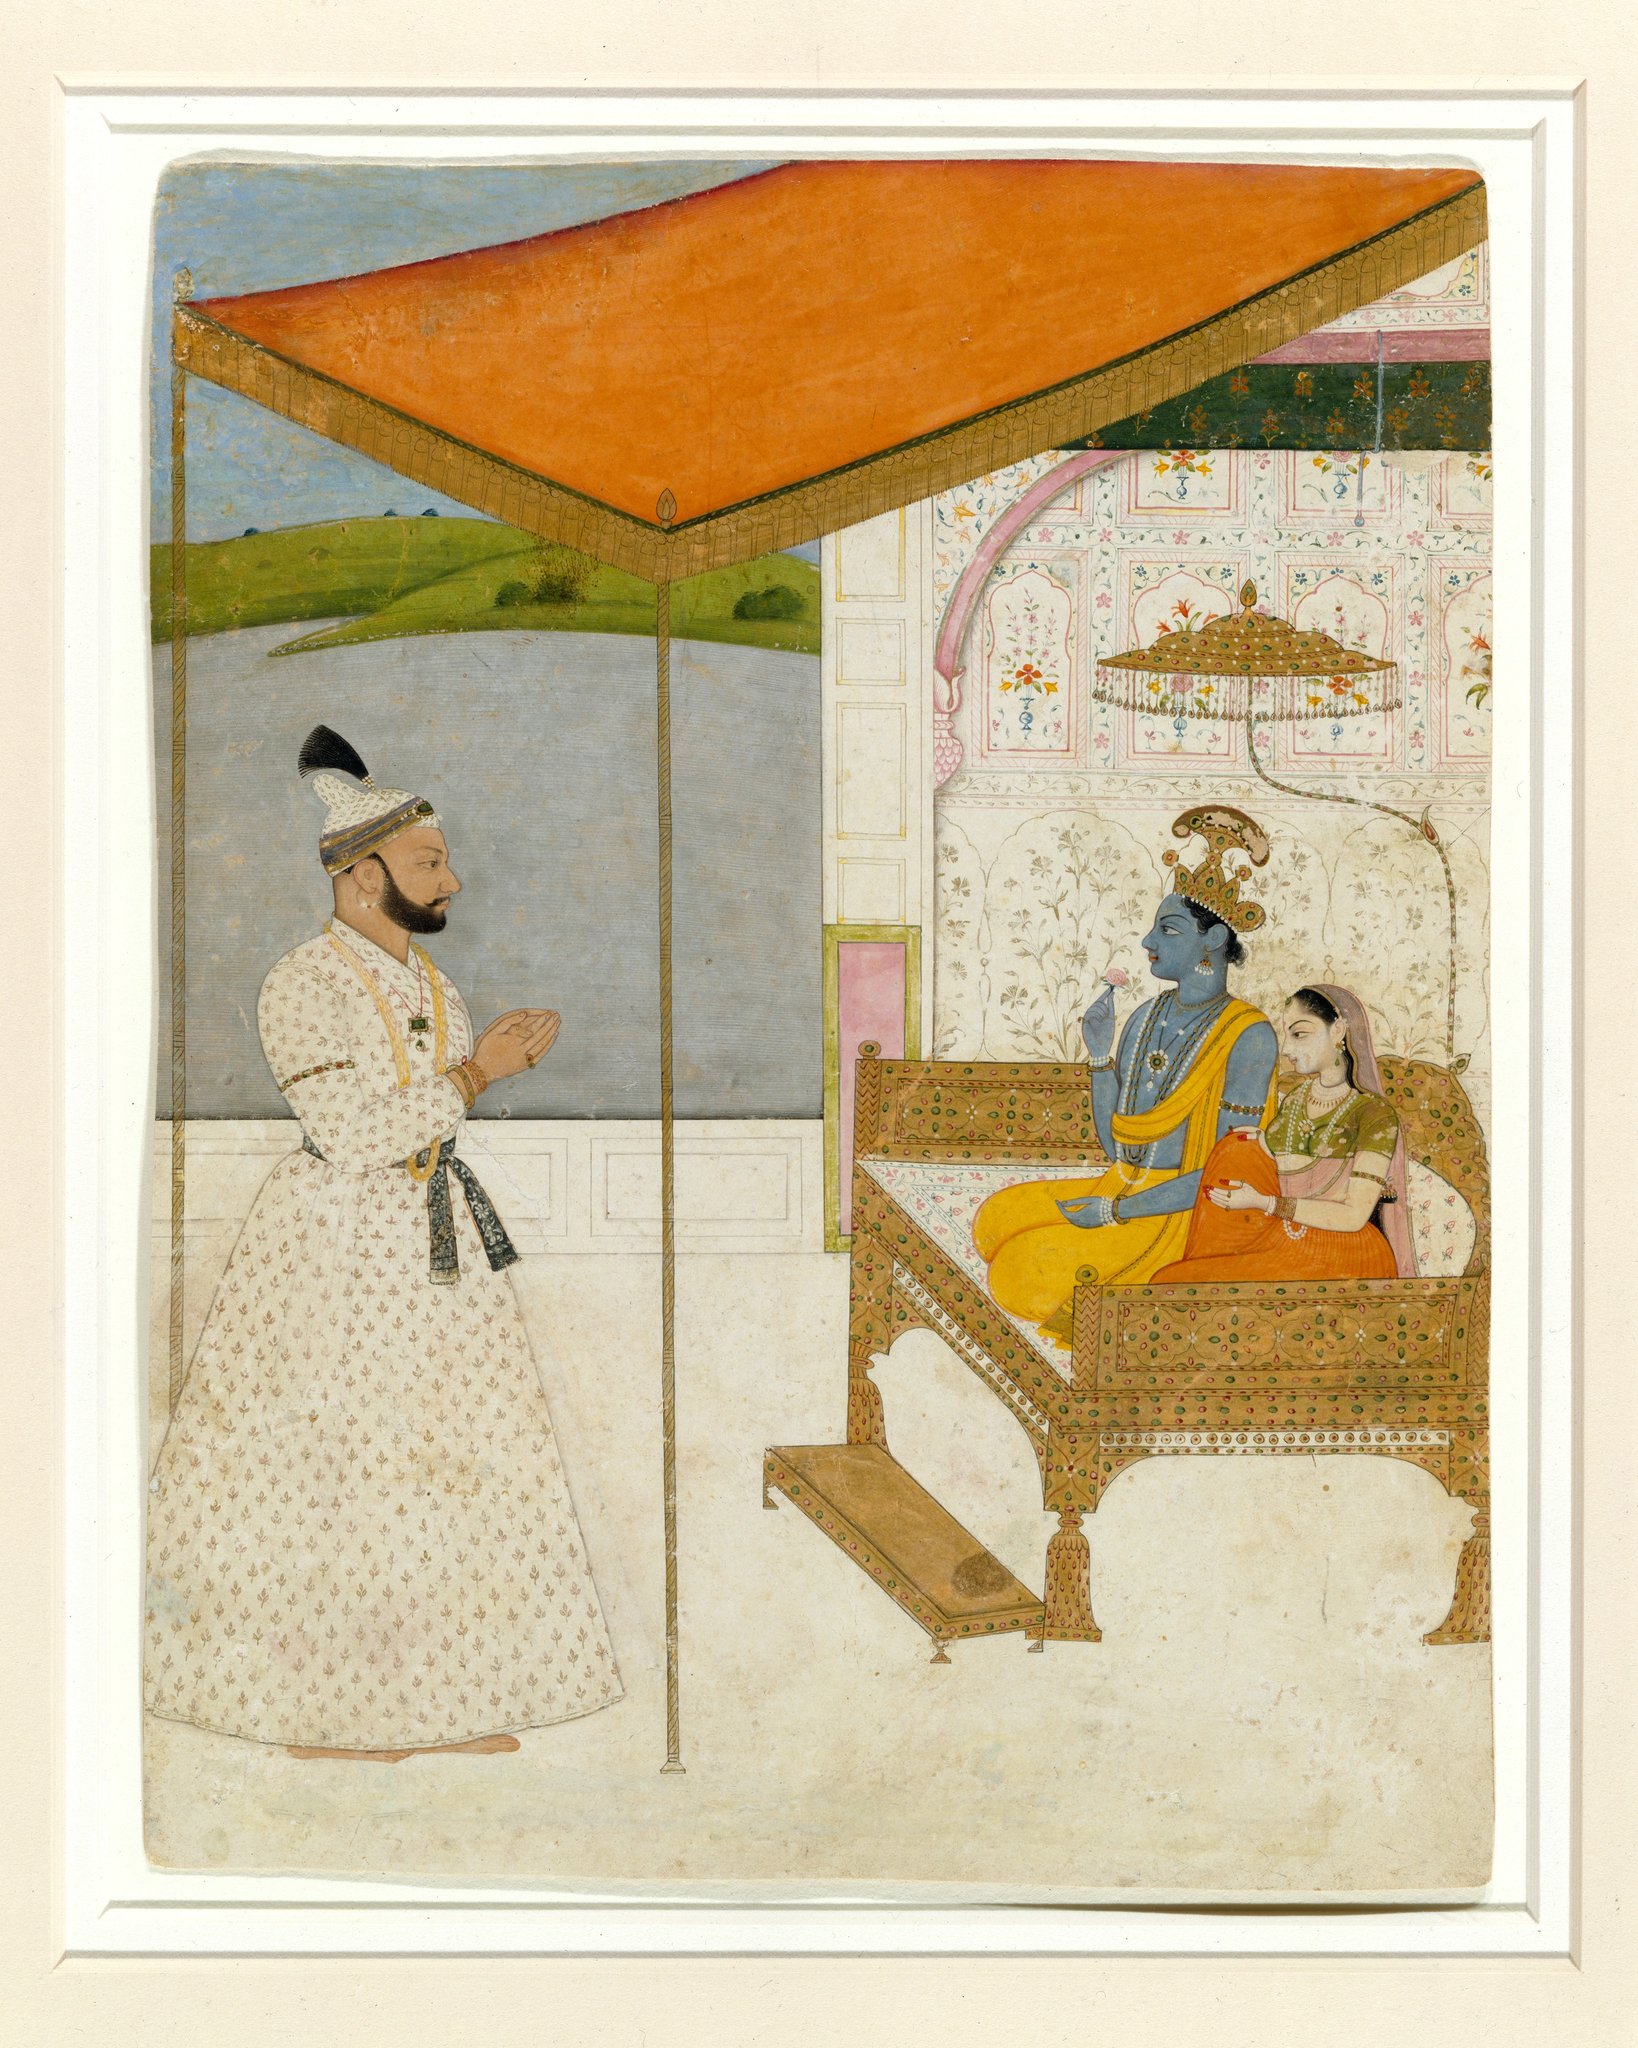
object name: painting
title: Raja Balwant Singh’s Vision of Krishna and Radha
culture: indian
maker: nainsukh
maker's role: artist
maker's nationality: indian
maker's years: 1725-1778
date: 1745-1750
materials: gold, ink, paper, watercolor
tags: couples,men,women,krishna,hinduism